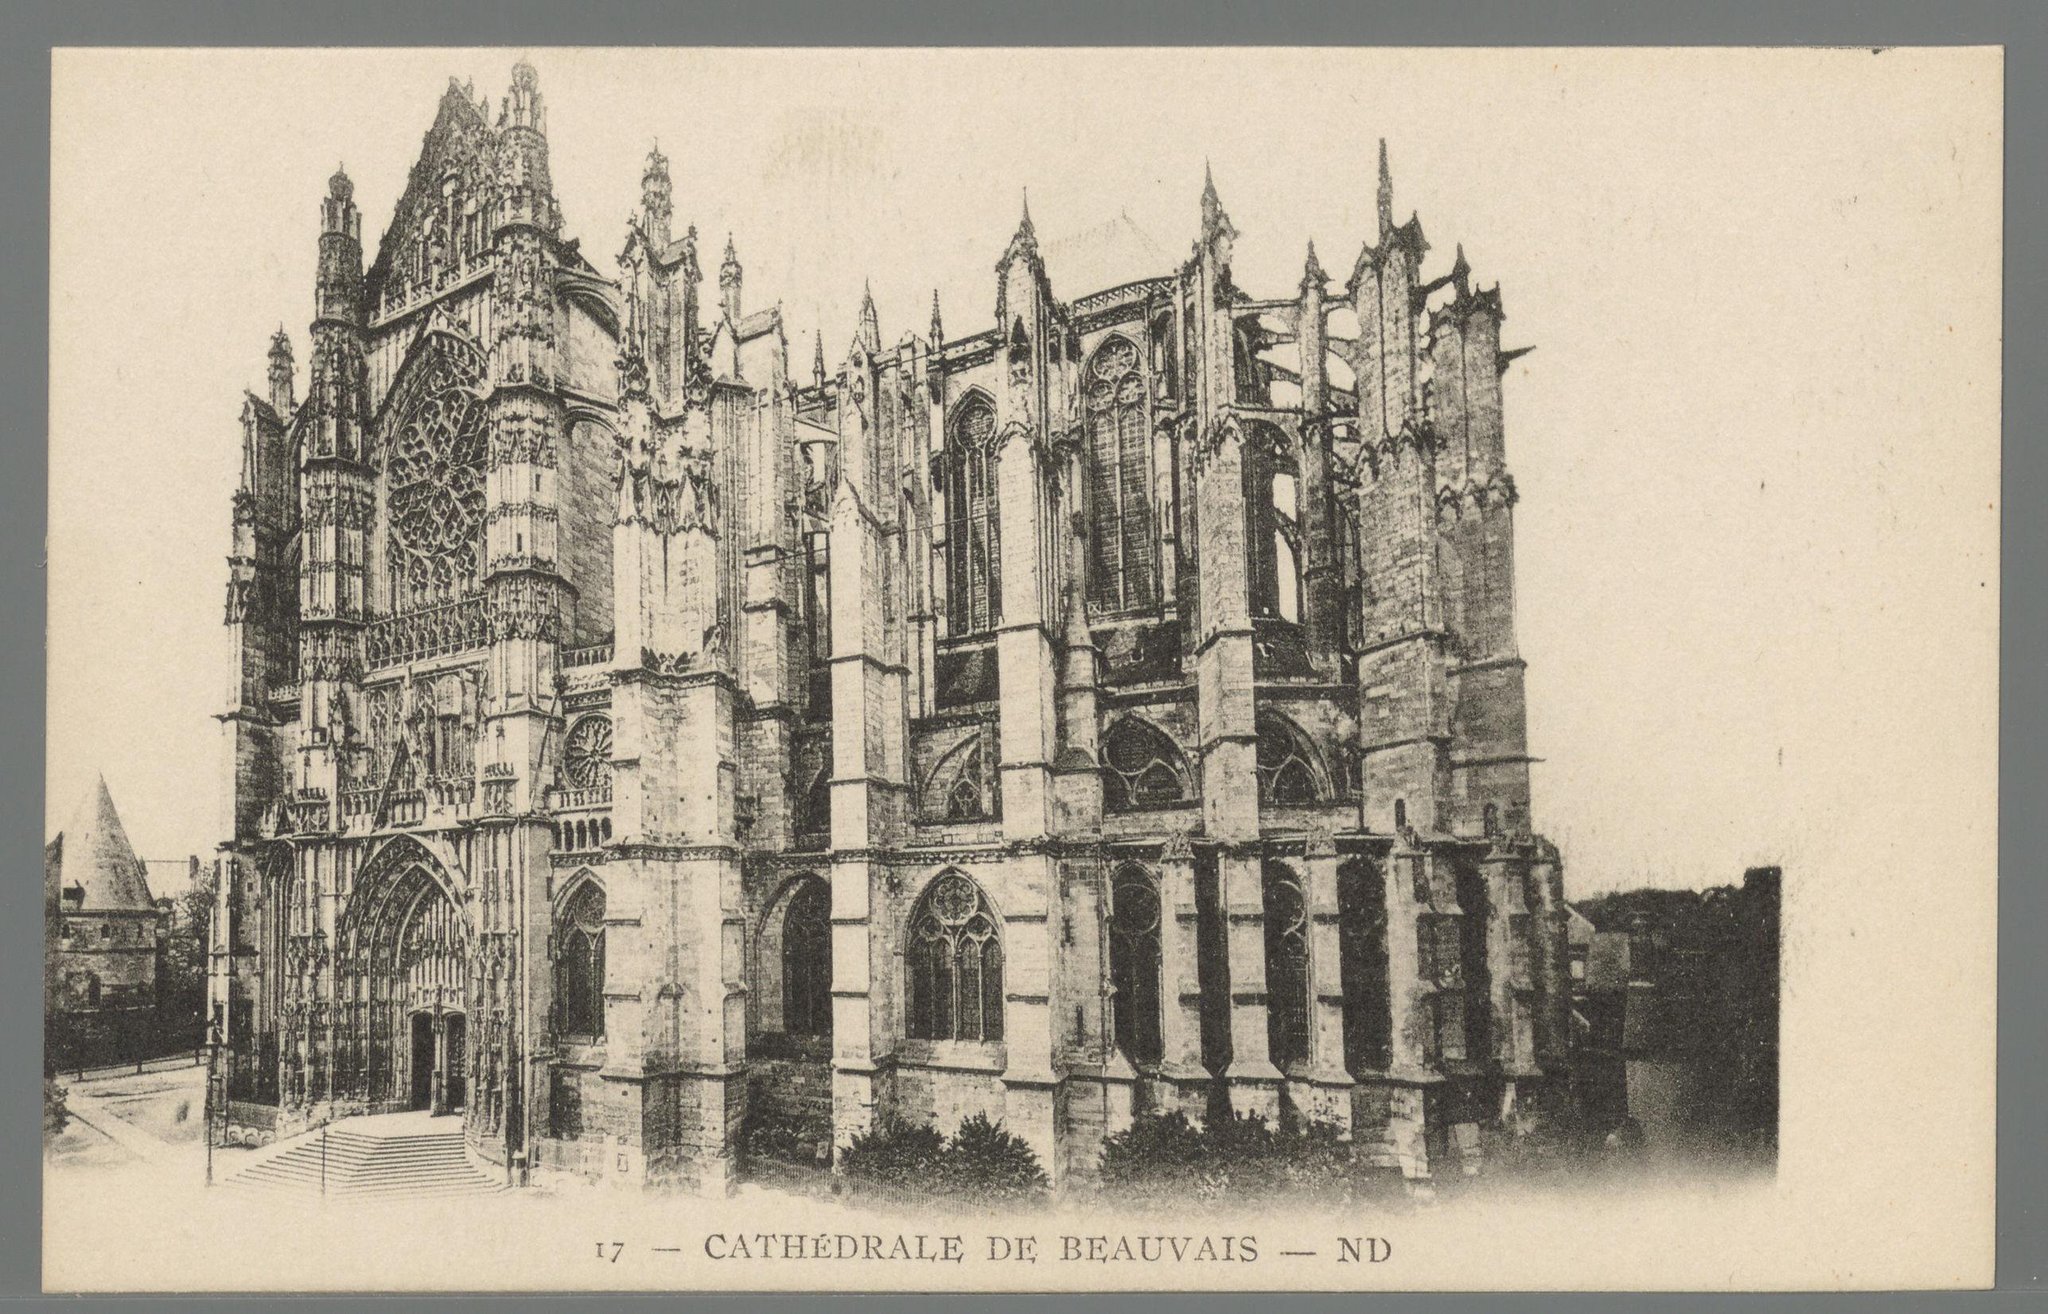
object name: ansichtkaart, prentbriefkaart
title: Cathédrale de Beauvais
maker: Anonymous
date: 1920-1932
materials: cardboard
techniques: photograph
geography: beauvais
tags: church (exterior)